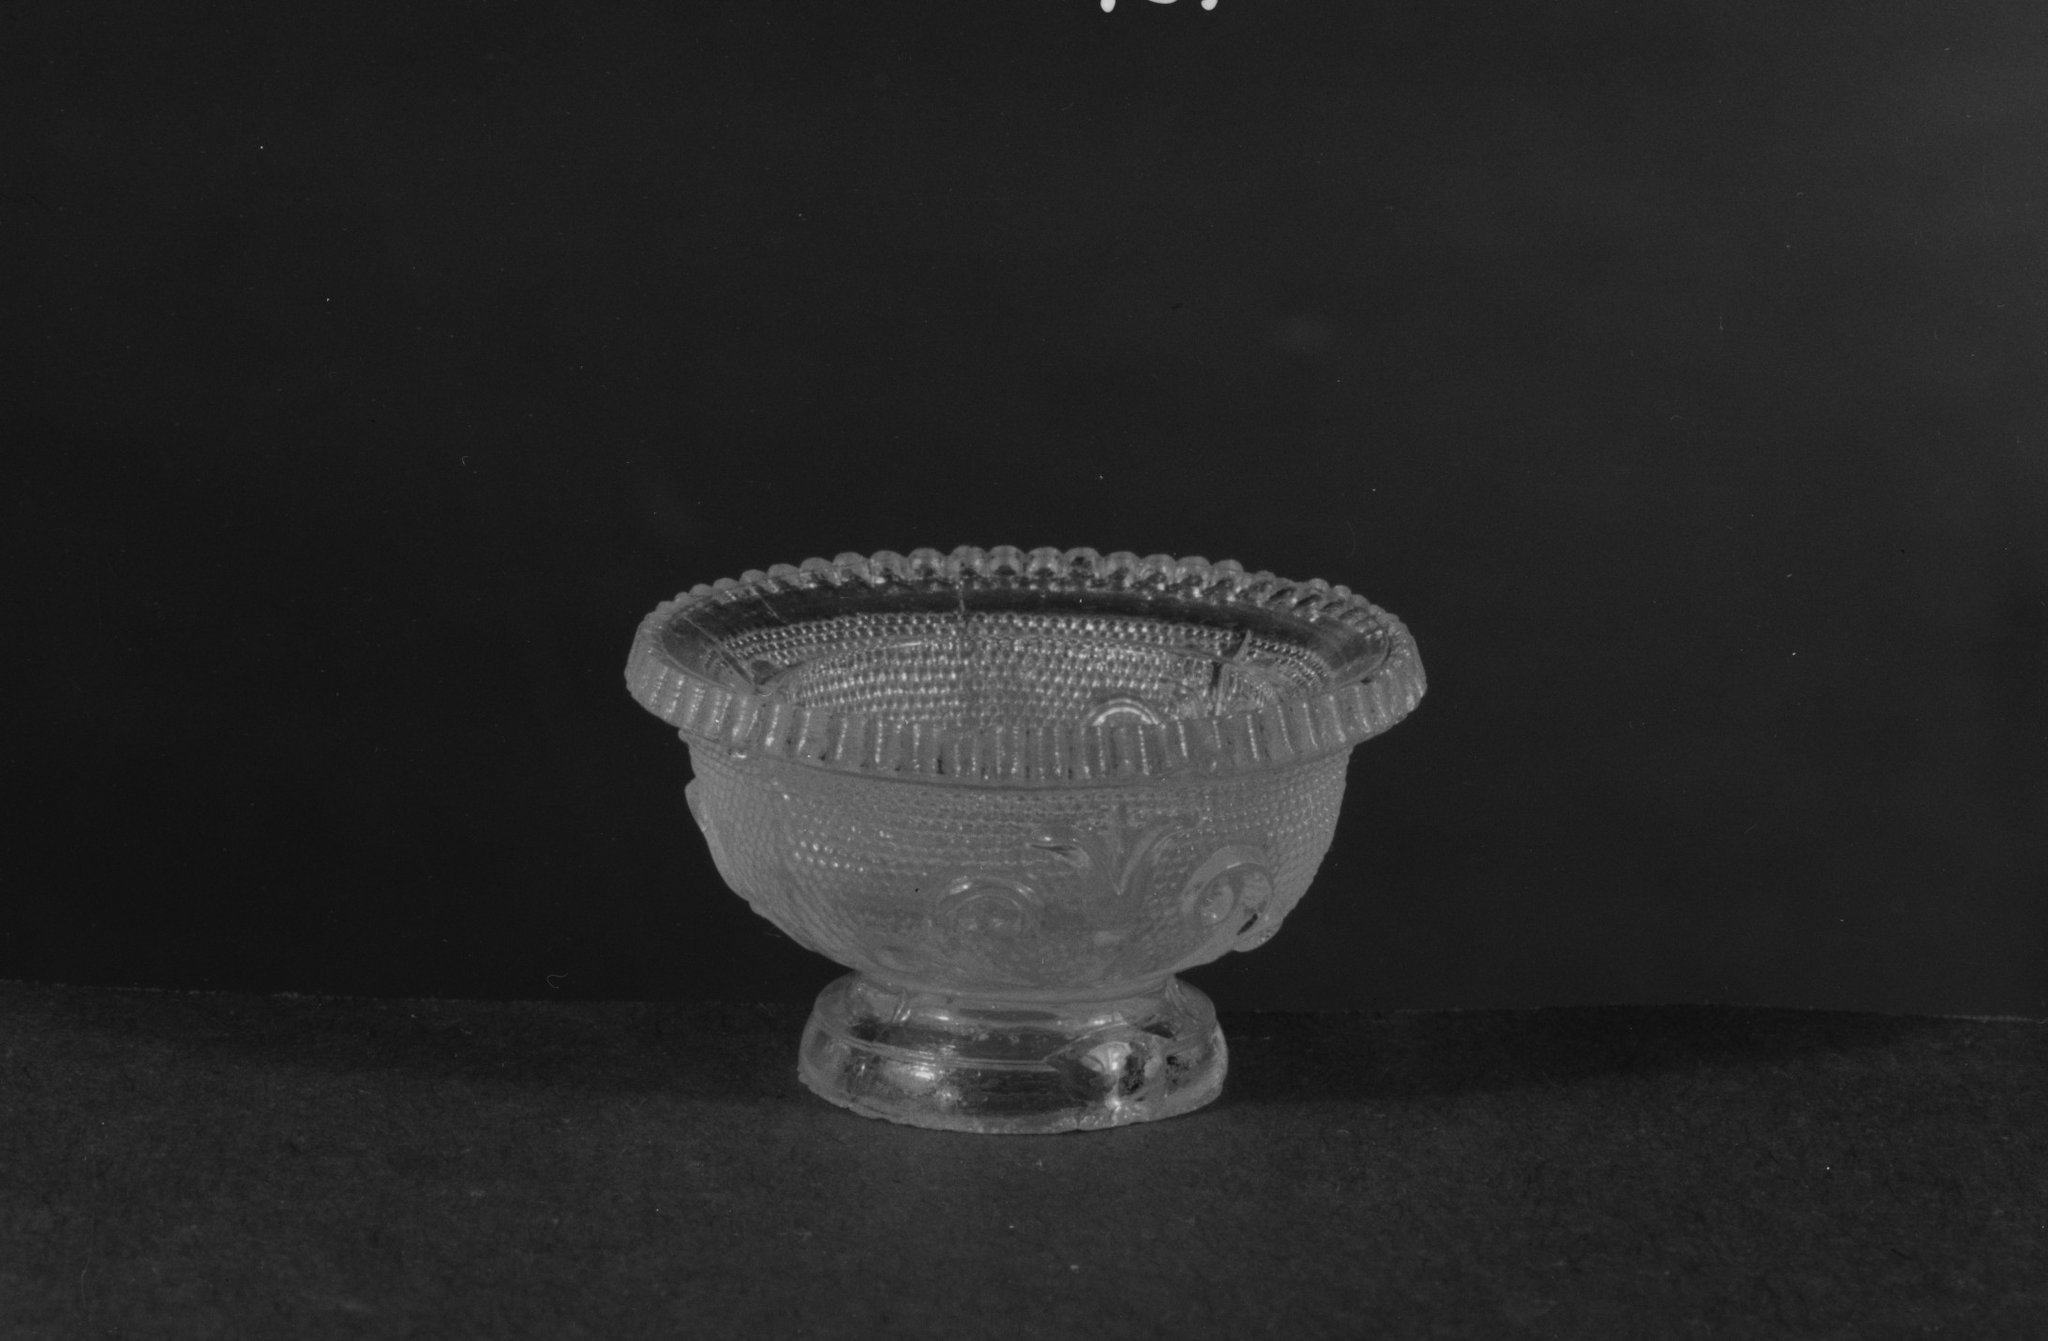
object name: bowl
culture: american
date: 1835-1850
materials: glass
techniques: pressed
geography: united states